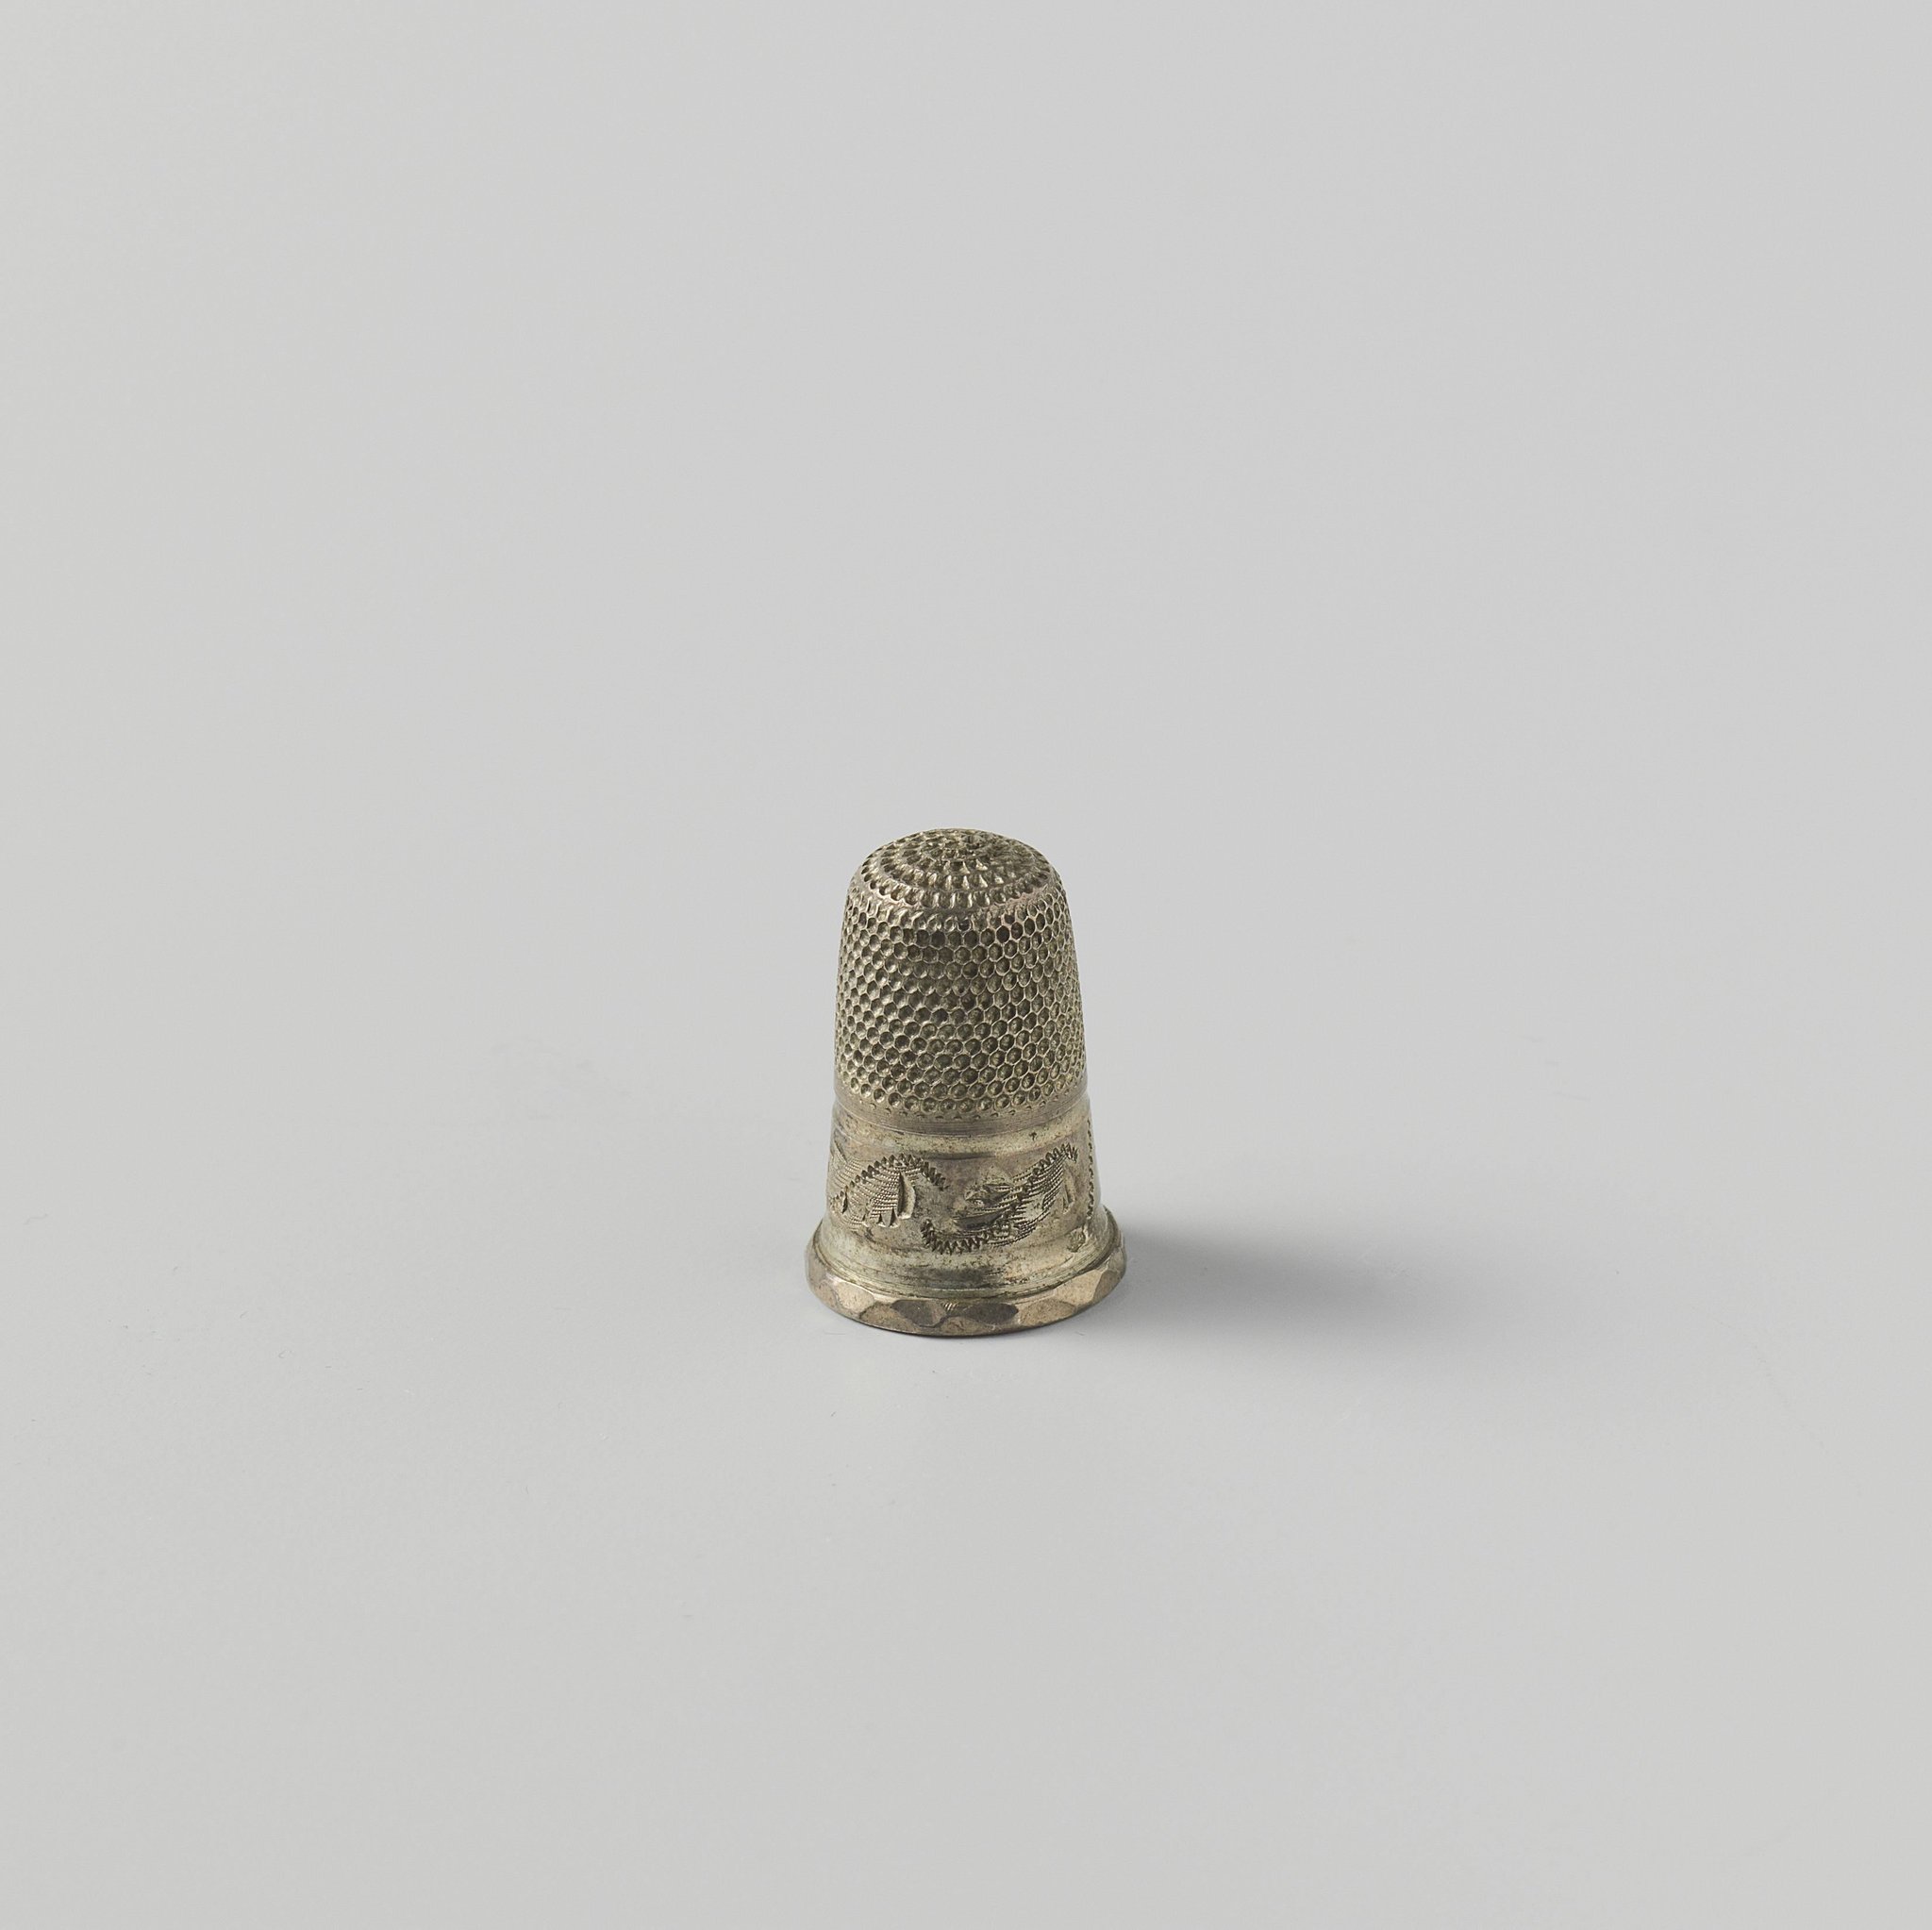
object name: miniature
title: Vingerhoed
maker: Anonymous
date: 1750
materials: silver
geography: netherlands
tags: thimble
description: Vingerhoed met afgeplatte ronde bovenkant. De rand is naar buiten gebogen en bewerkt. De zijwand is aan de onderkant gegraveerd met bladeren en zig-zag motief. De vingerhoed is gemerkt met een zwijnskop.